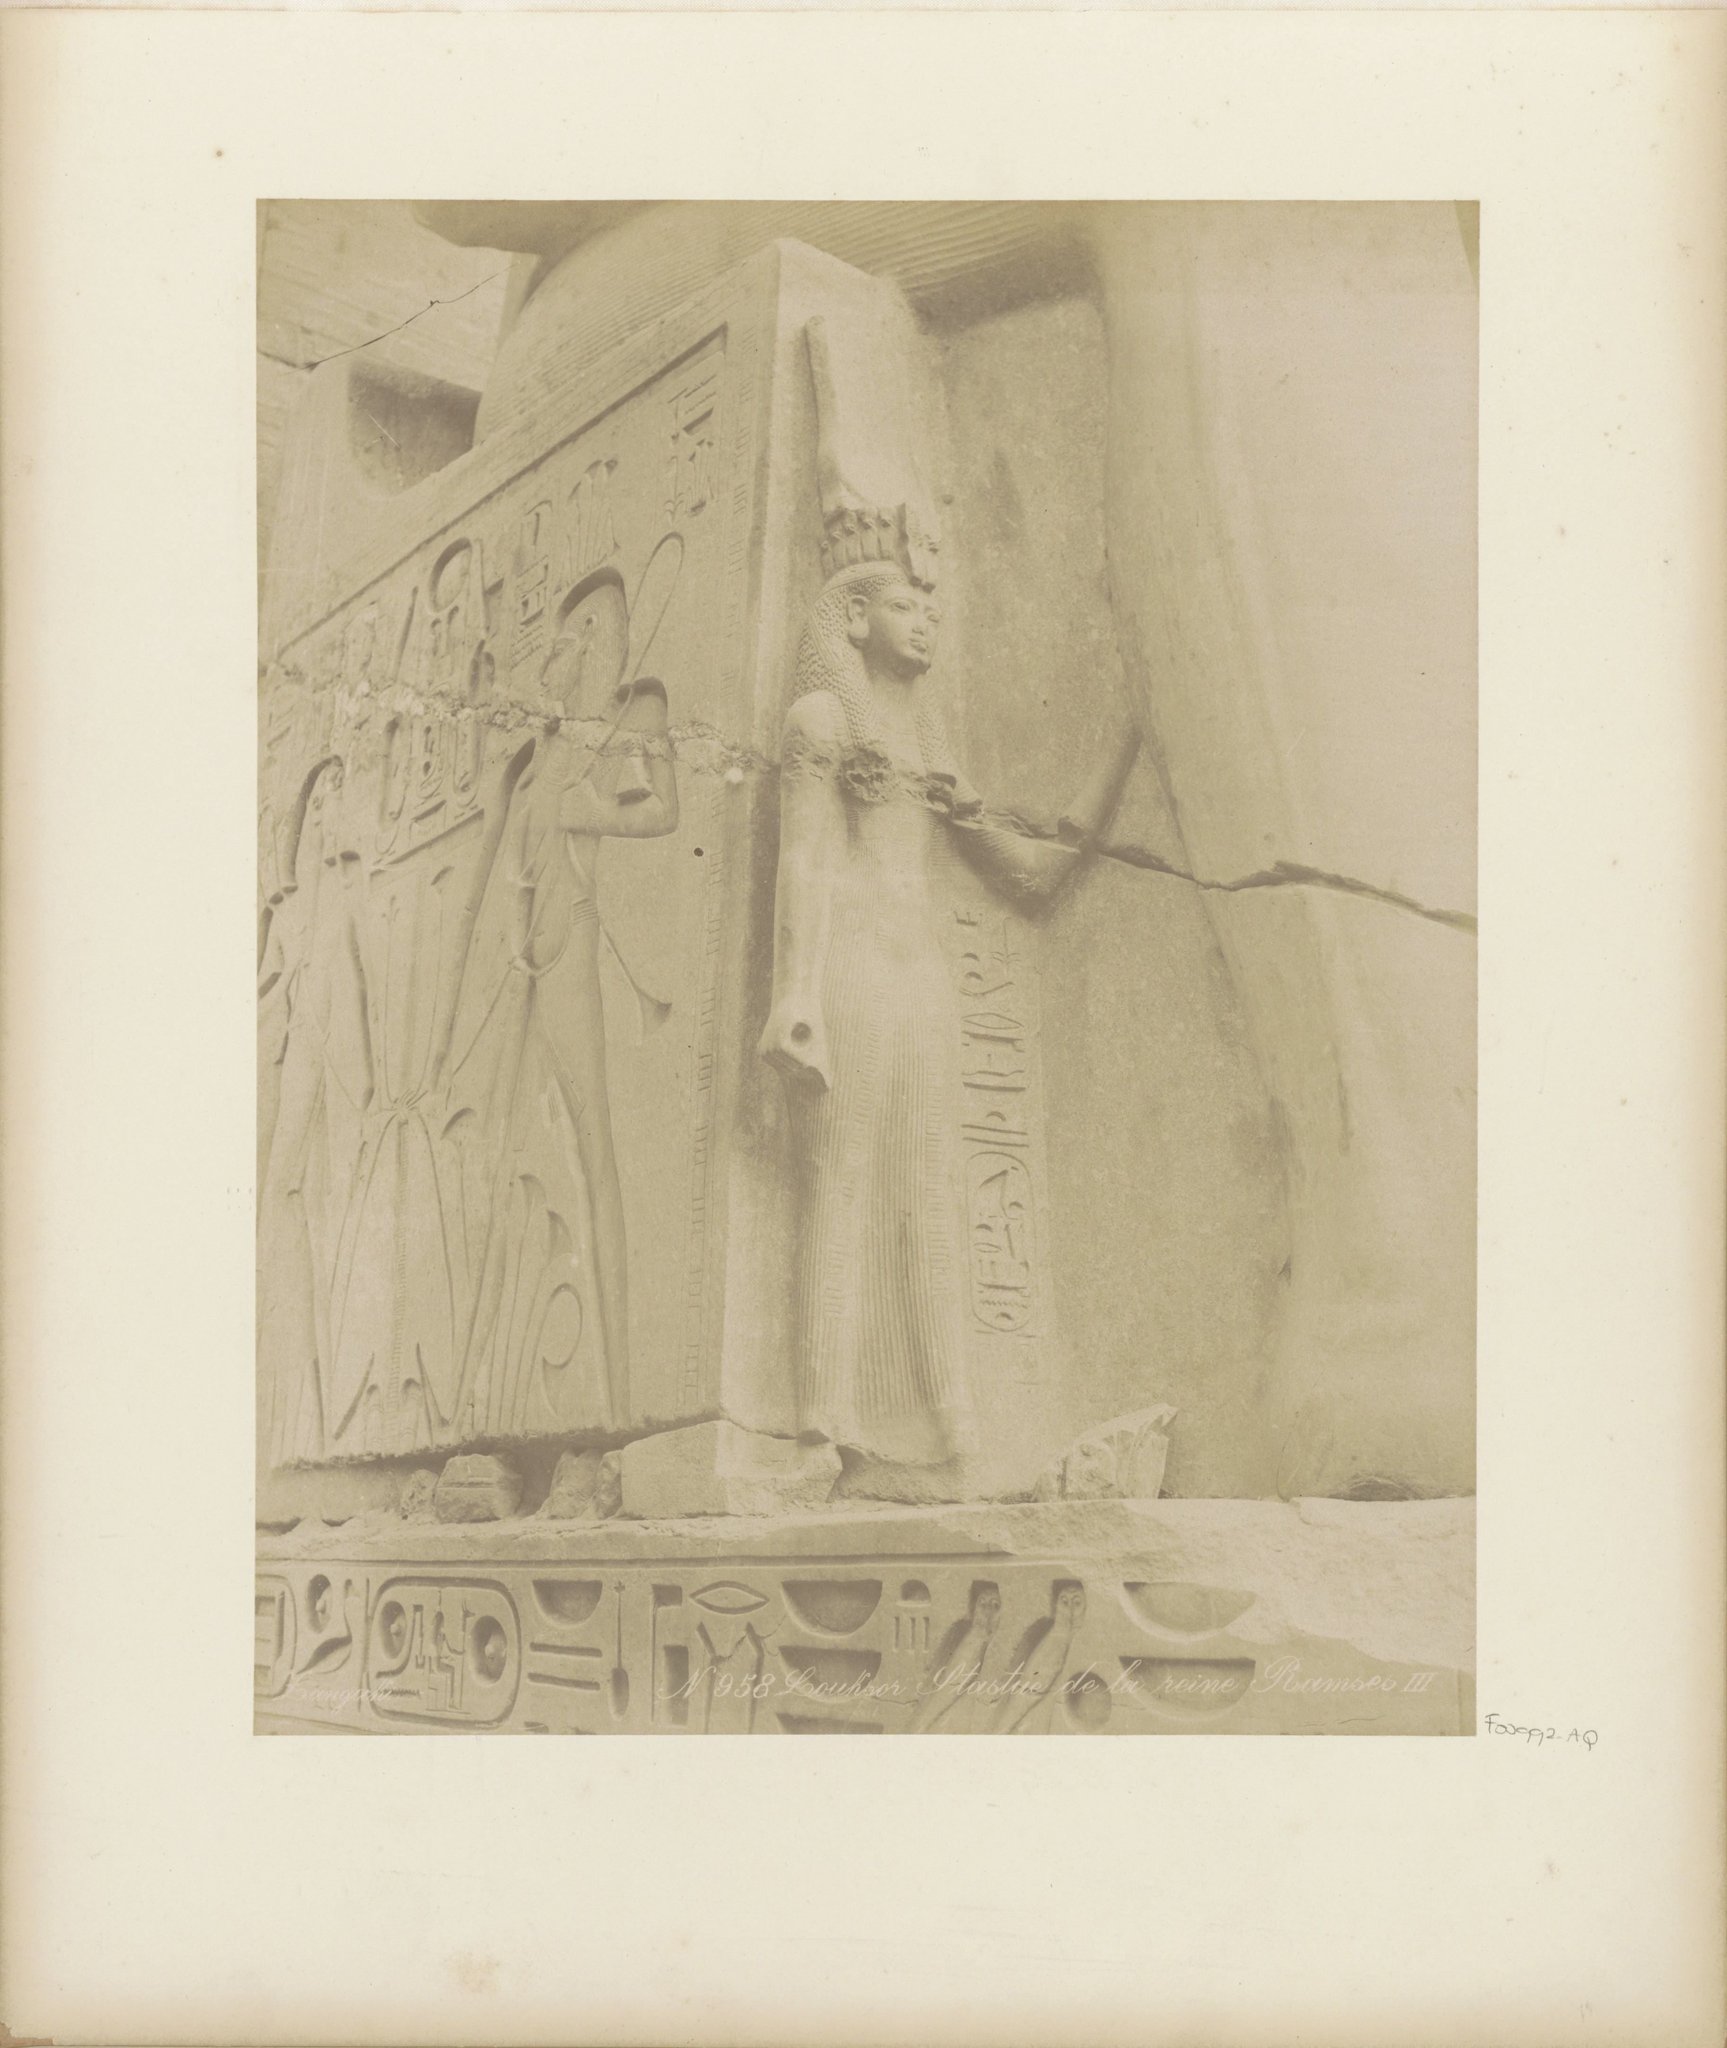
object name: photograph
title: Beeldhouwwerk van de koningin van farao Ramses II in Luxor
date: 1870-1890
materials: cardboard, paper, photographic support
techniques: albumen print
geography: luxor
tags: piece of sculpture, reproduction of a piece of sculpture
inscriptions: negative number: ‘958’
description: Anders dan de titel op het object vermeldt, gaat het hier om Ramses II